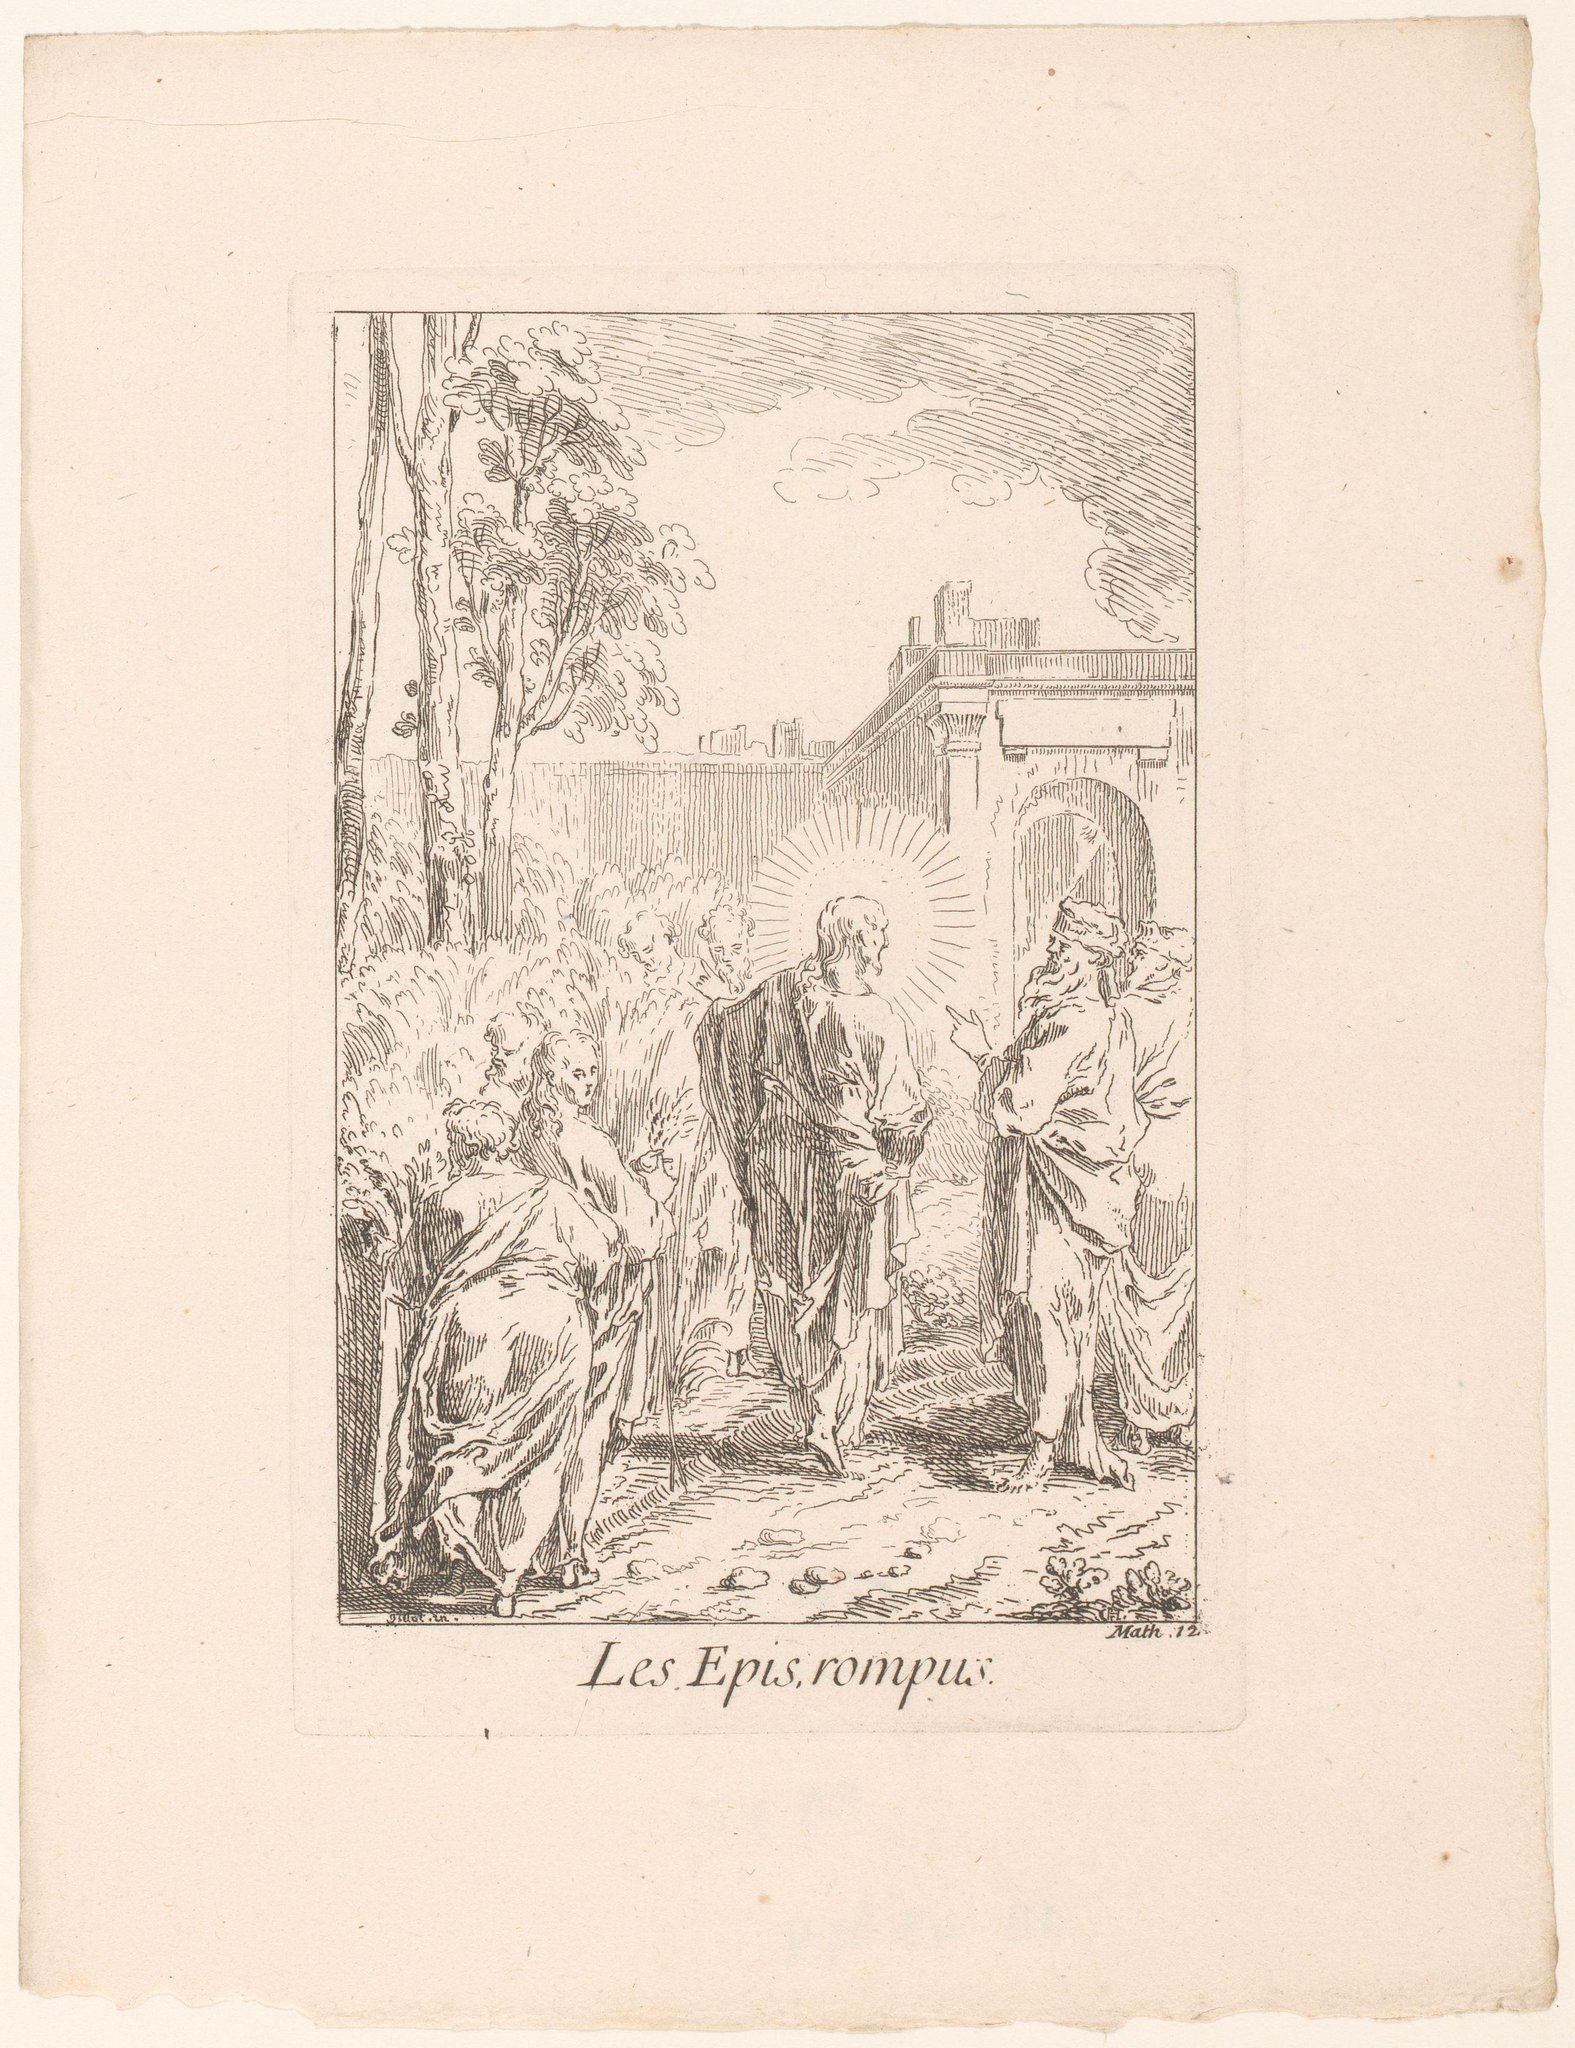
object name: print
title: Leven en passie van Christus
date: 1705-1732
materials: paper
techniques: etching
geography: paris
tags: disciples pluck ears of corn on sabbath, and eat (matthew 12:1-8; mark 2:23-28; luke 6:1-5)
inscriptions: collector's mark: Lugt 2228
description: Maakt deel uit van een serie met zestig prenten met als thema het leven van Christus.